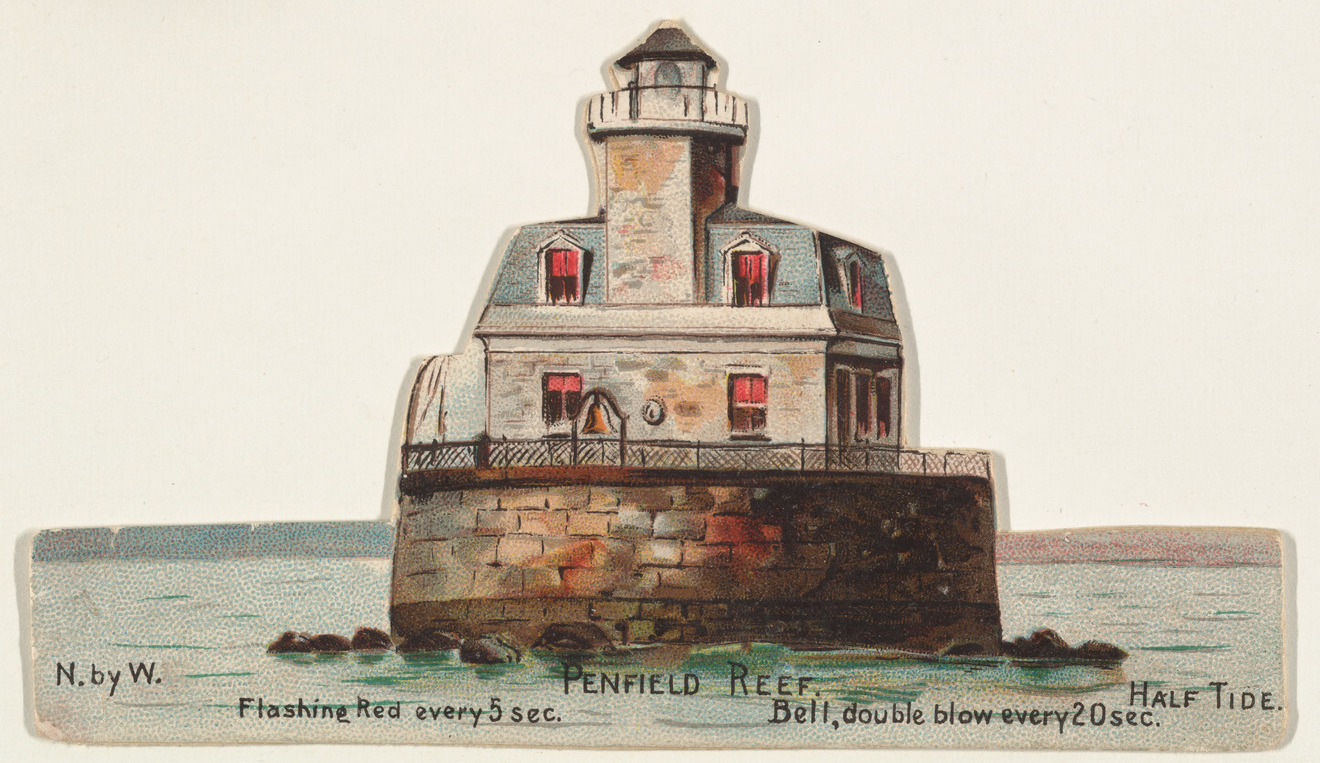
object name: print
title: Penfield Reef, from the Lighthouses series (N119) issued by Duke Sons & Co. to promote Honest Long Cut Tobacco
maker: w. duke, sons & co.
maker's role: publisher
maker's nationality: american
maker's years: 1870-1920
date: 1889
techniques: color lithograph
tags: lighthouses